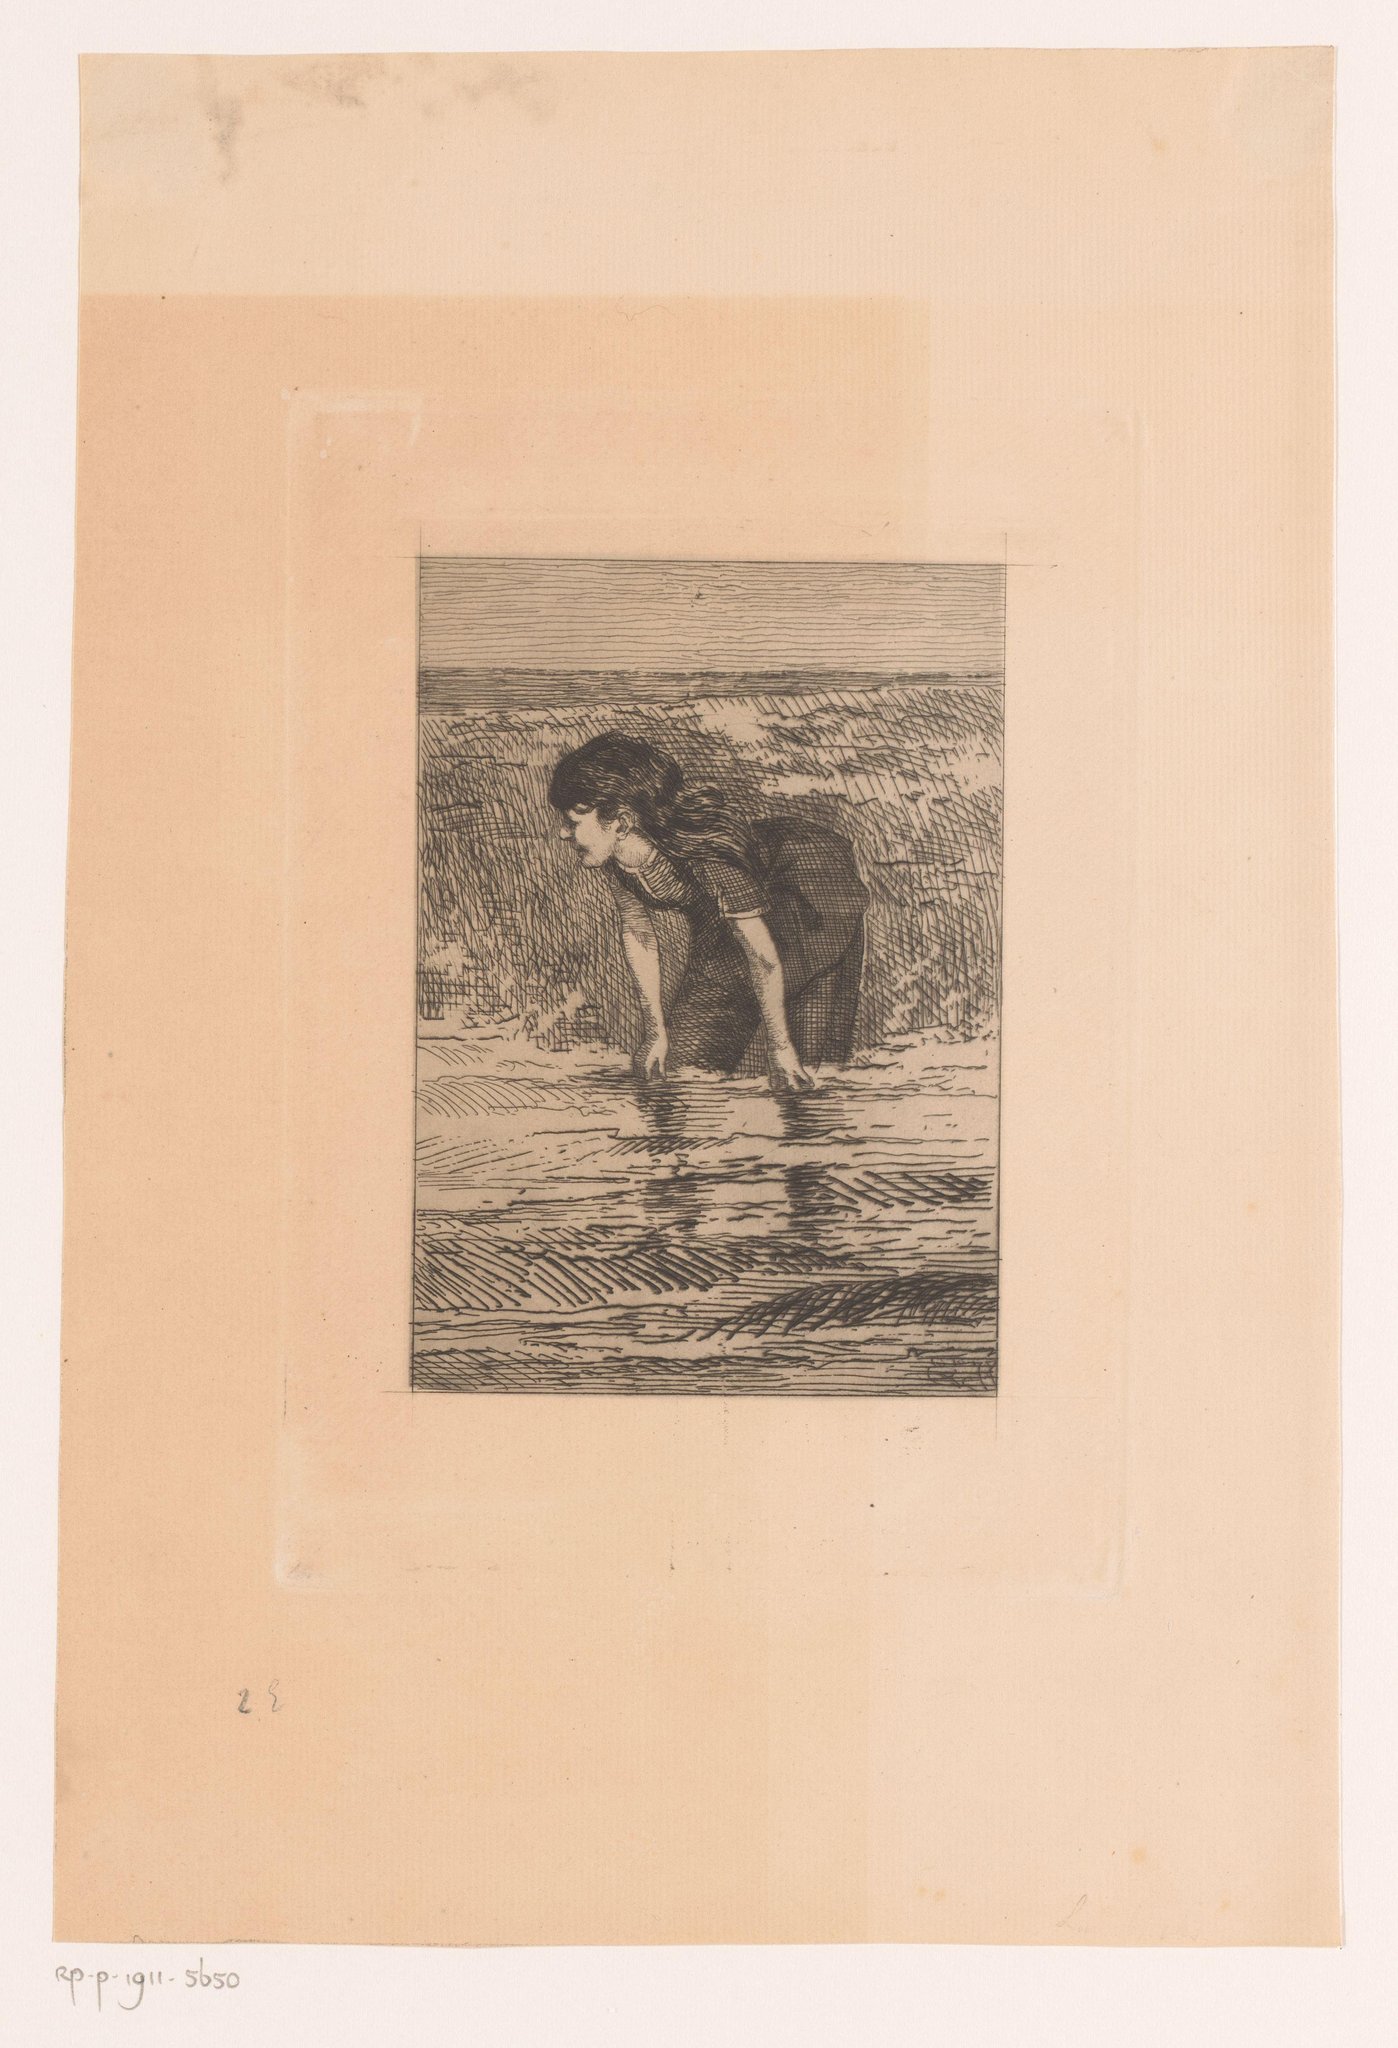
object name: print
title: Meisje in de branding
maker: edmond lambrichs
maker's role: print maker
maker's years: 1830-1887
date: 1877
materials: paper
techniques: drypoint, etching, intaglio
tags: in or beside the water (on the beach)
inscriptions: collector's mark: Lugt 2228, annotation: ‘2 E’